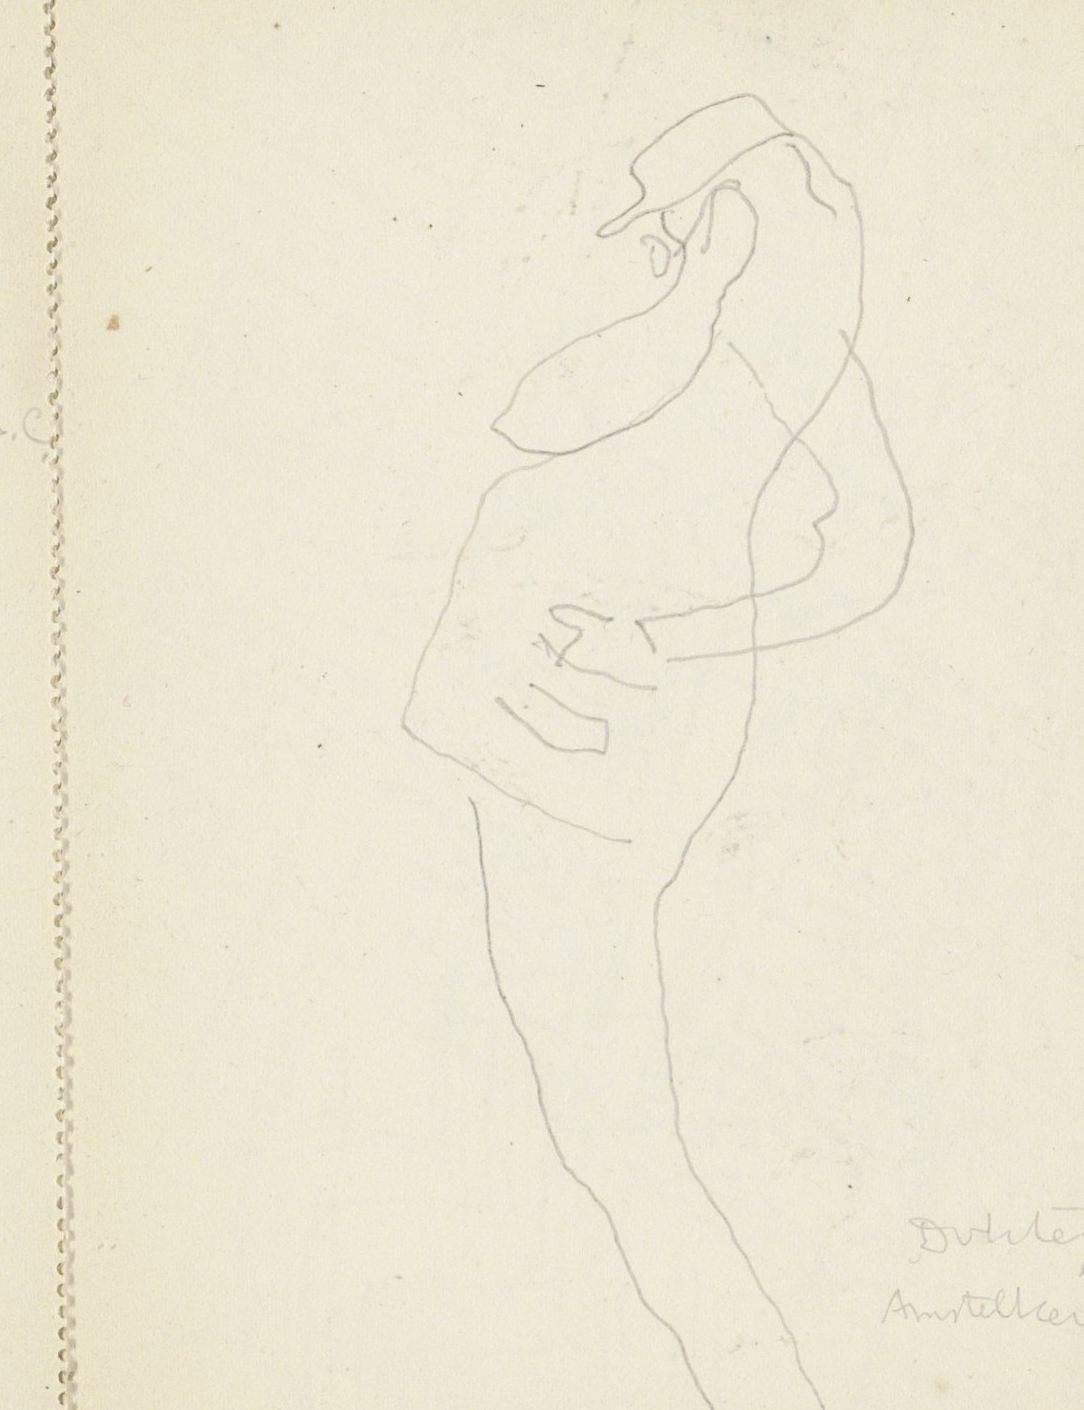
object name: sketchbook leaf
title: Portret van dokter A.B. Amstelkerk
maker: reijer stolk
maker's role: draughtsman, print maker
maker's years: 1896-1945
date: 1916-1945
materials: paper, pencil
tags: anonymous historical person portrayed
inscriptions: annotation: ‘Dokter/ a.b./ Amstelkerk’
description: Blad 2 recto uit een schetsboek met 60 bladen.